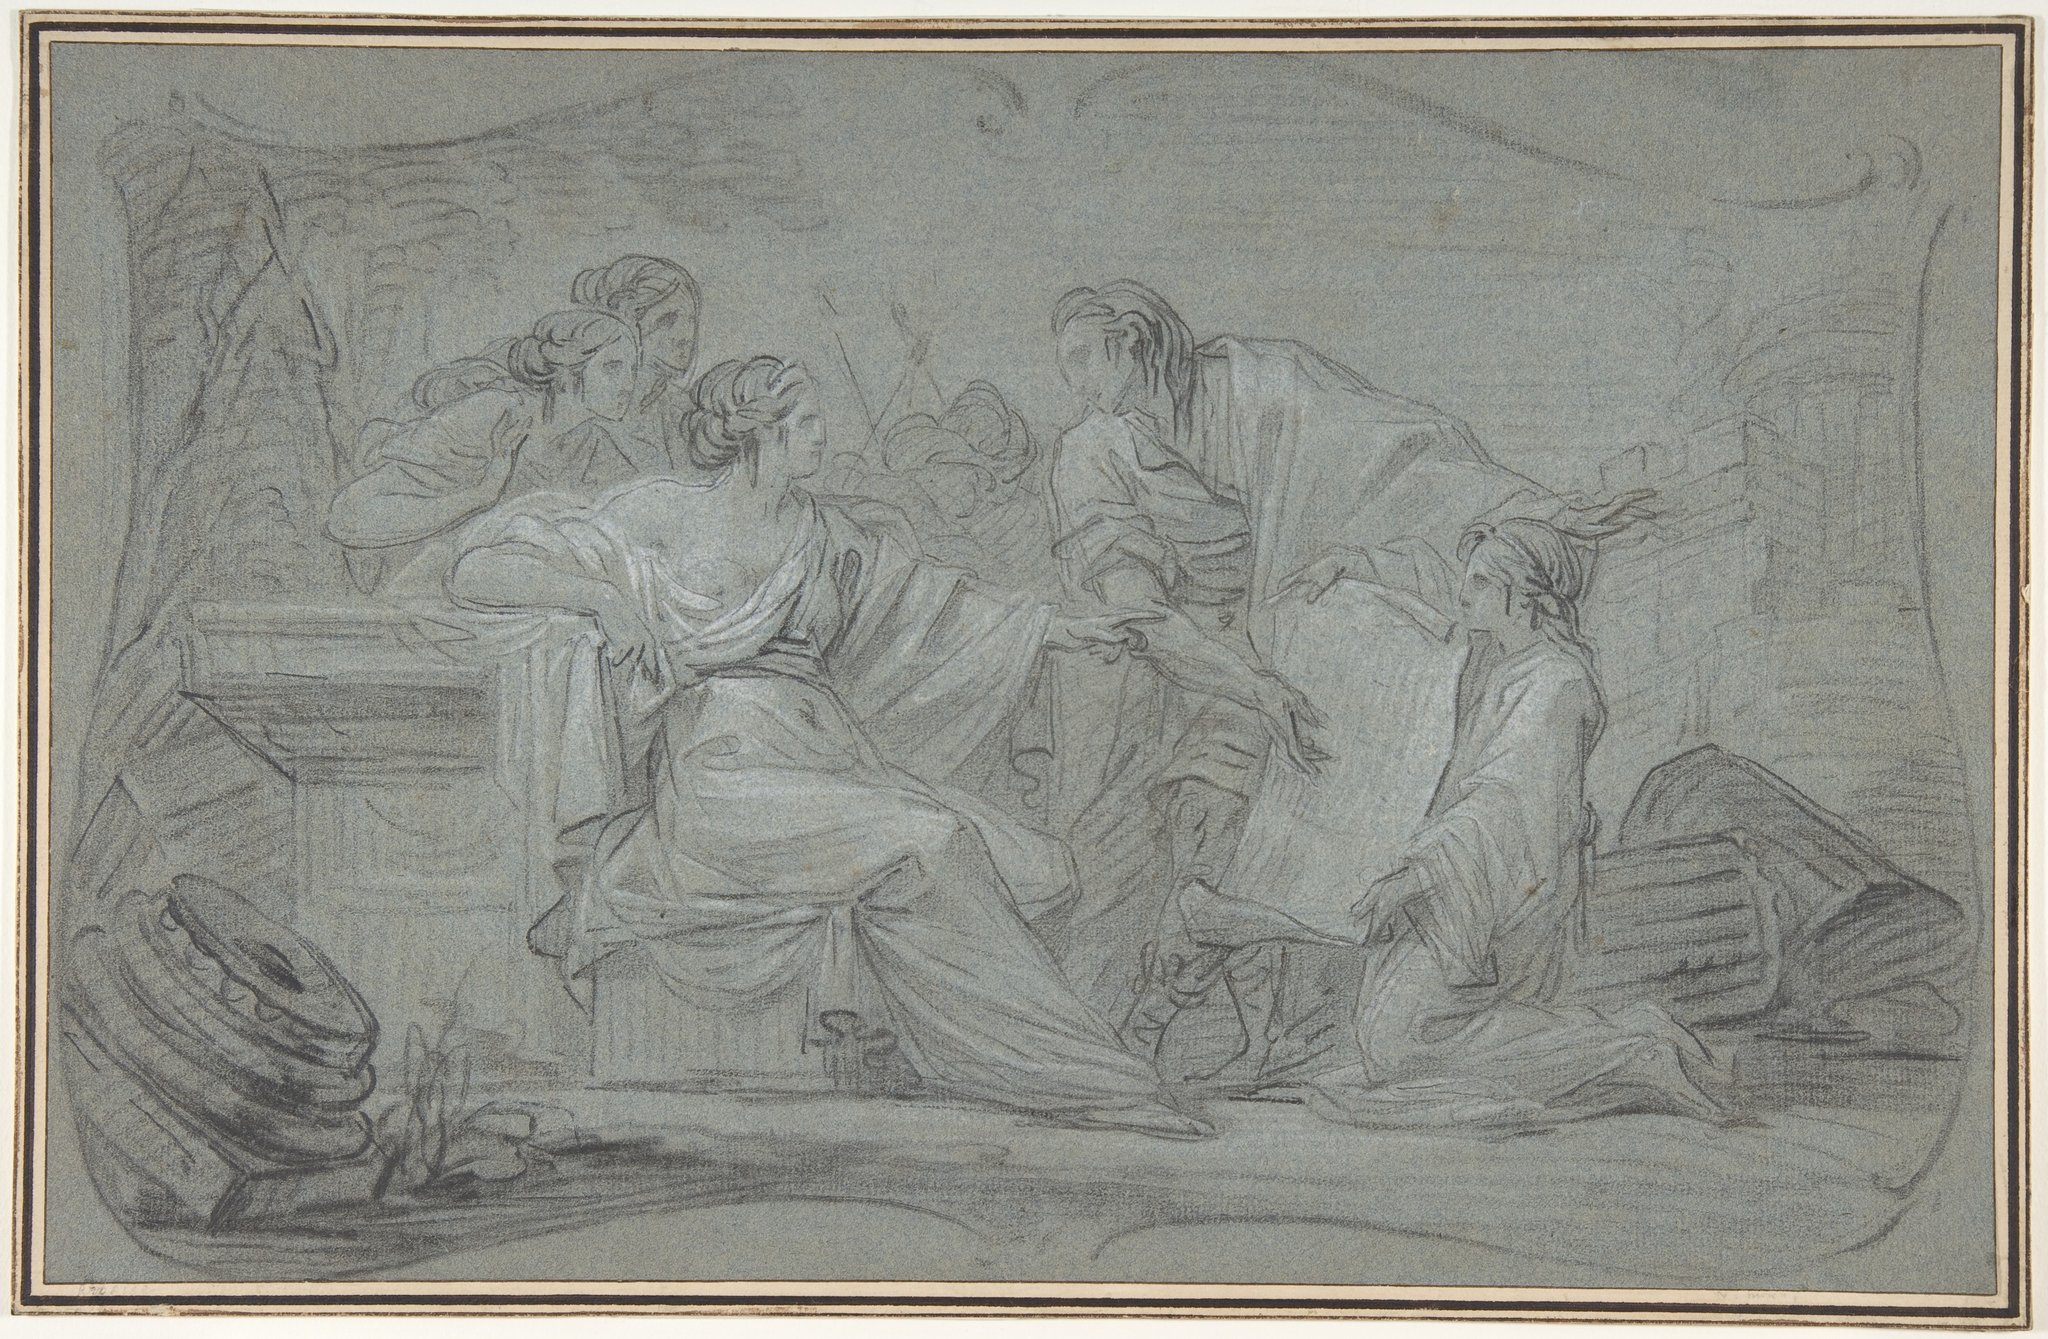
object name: drawing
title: Semiramus Inspecting a Plan of Babylon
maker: jean simon berthélemy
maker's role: artist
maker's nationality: french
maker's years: 1742-1811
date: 1750-1811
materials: chalk, paper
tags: men,women